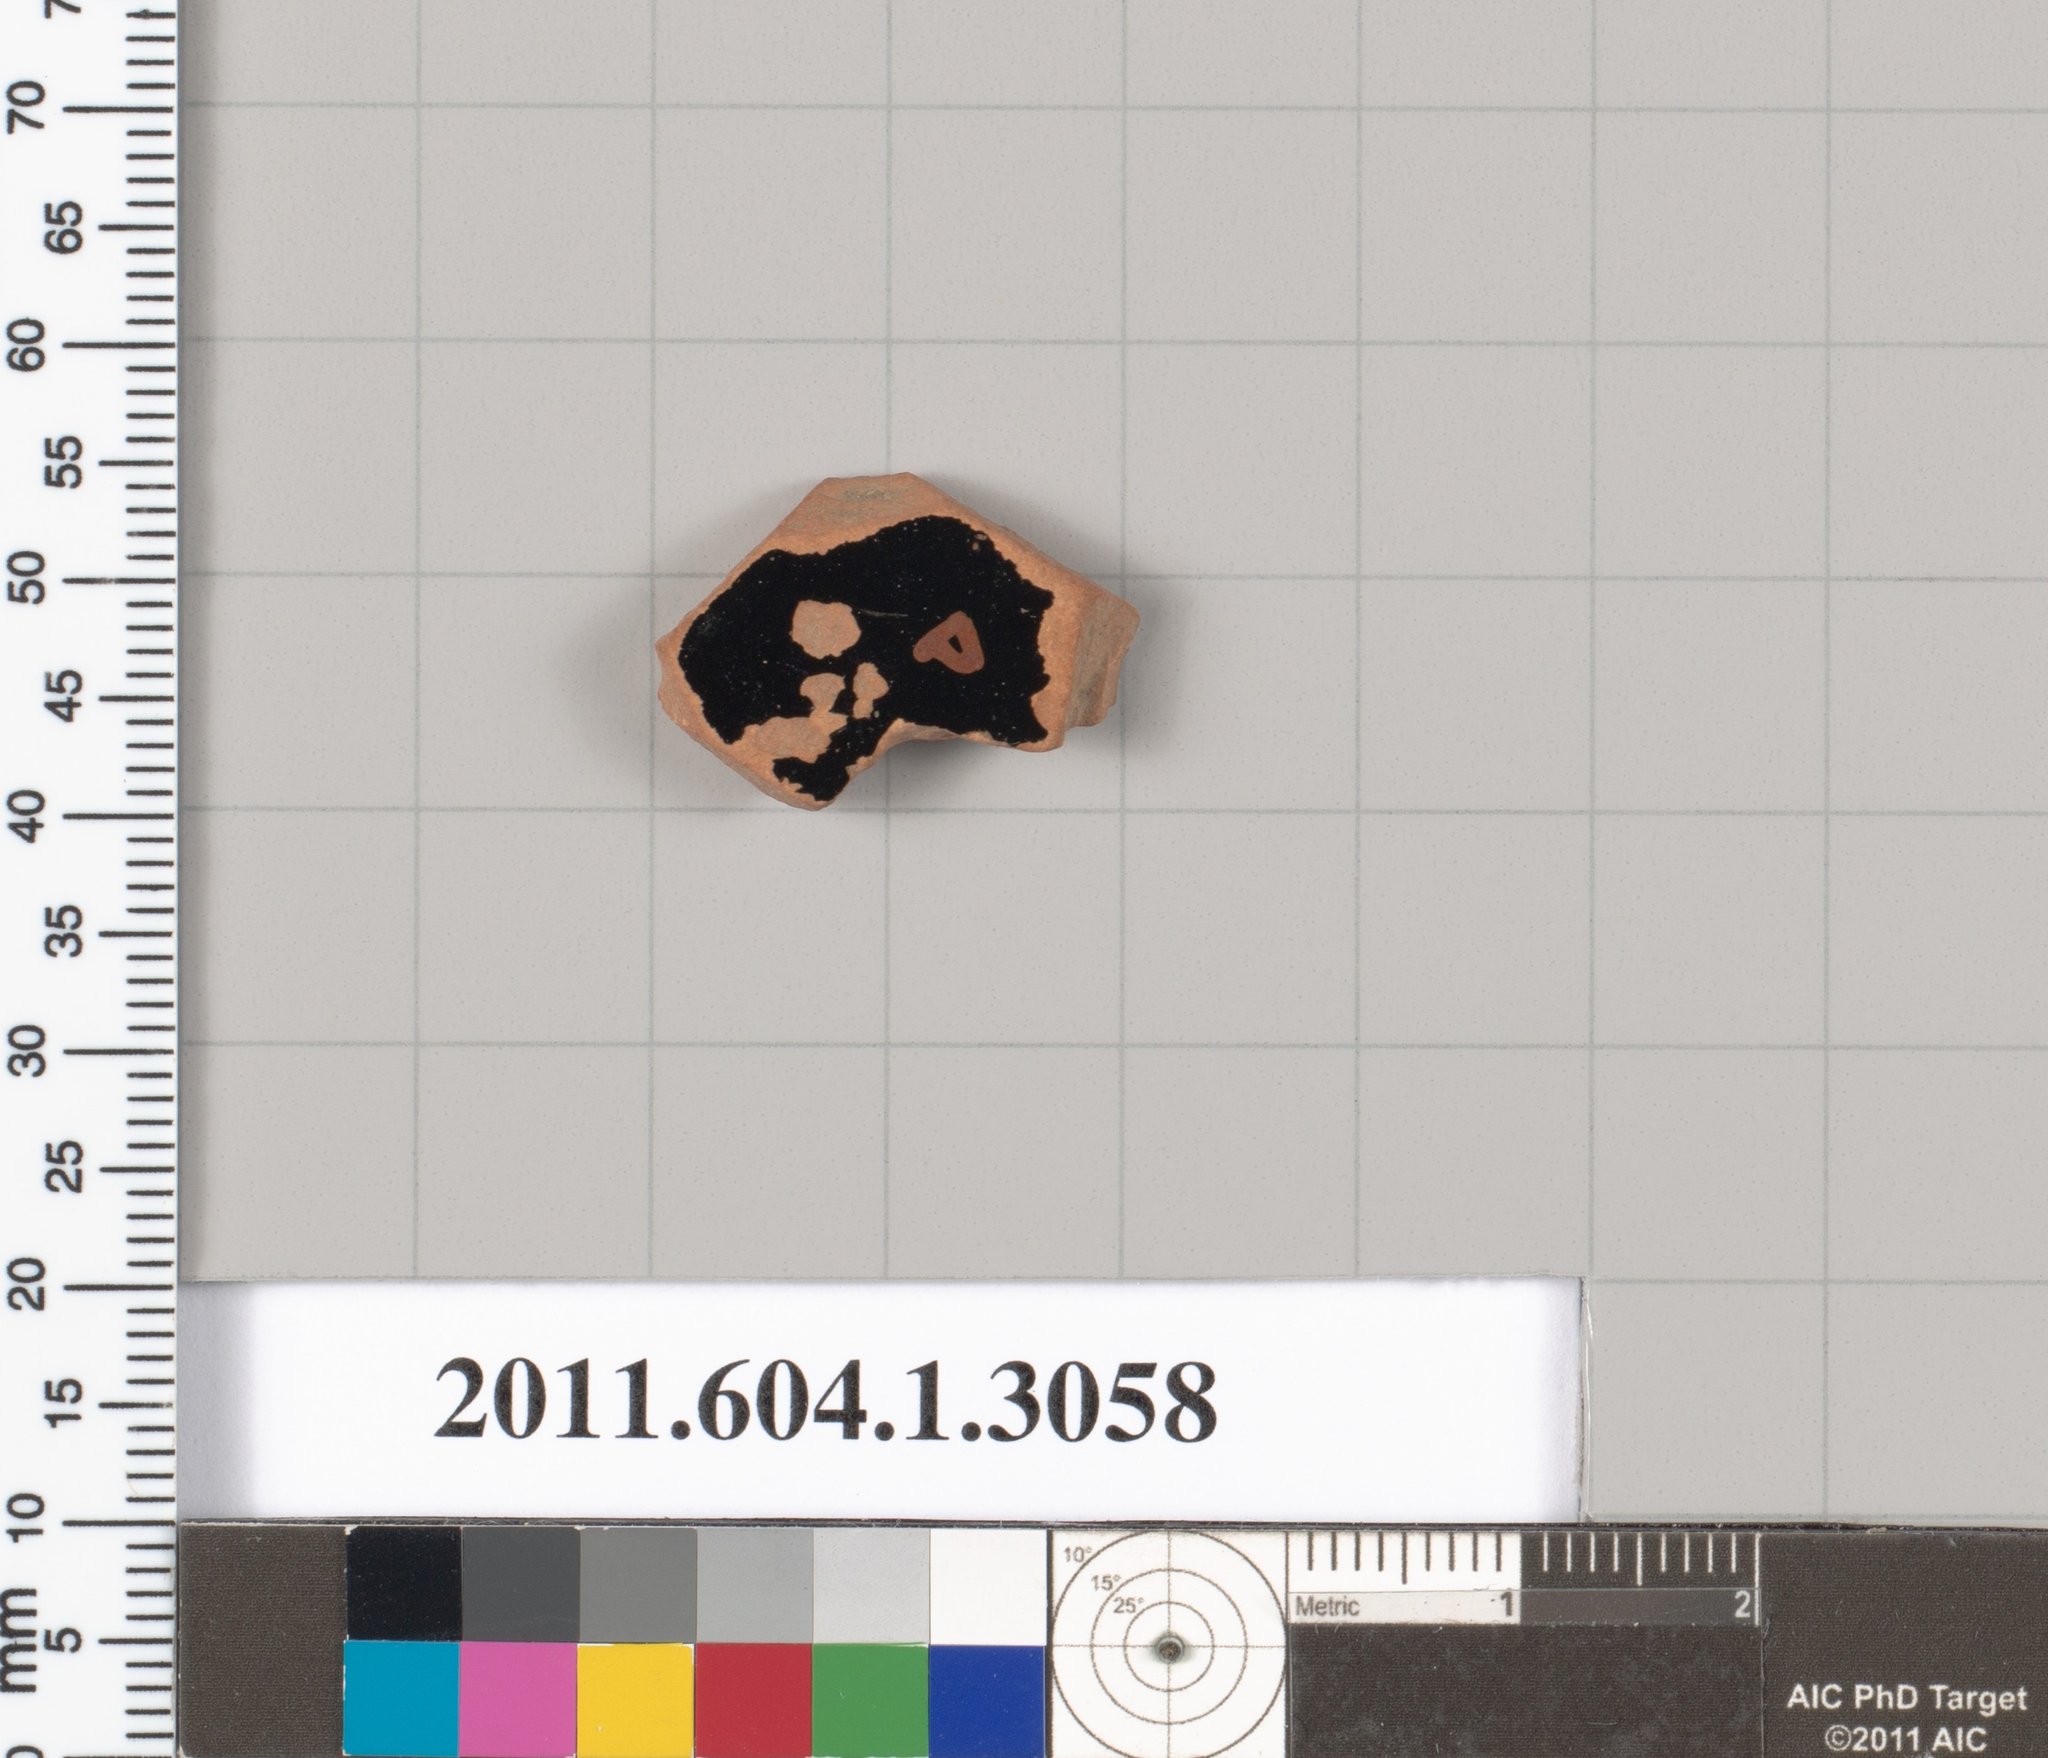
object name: kylix fragment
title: Terracotta fragment of a kylix (drinking cup)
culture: greek, attic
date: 500-475 BCE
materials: terracotta